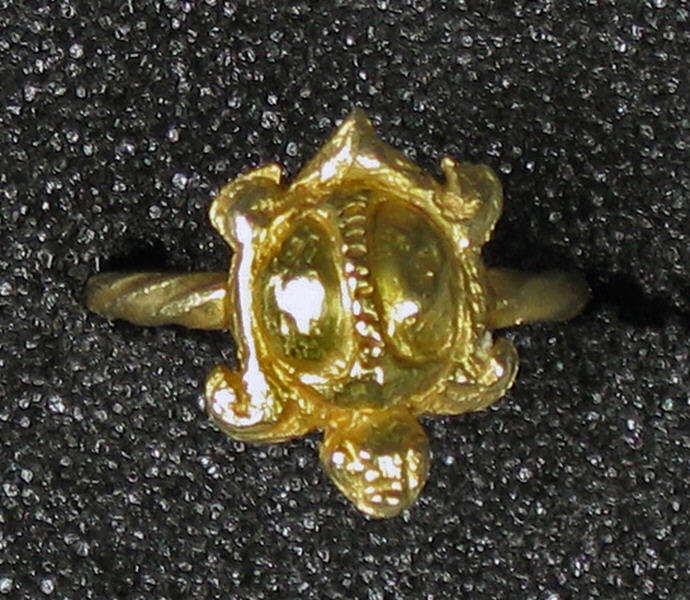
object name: ring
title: Ring with Turtle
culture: indonesian, central java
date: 701-1200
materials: gold